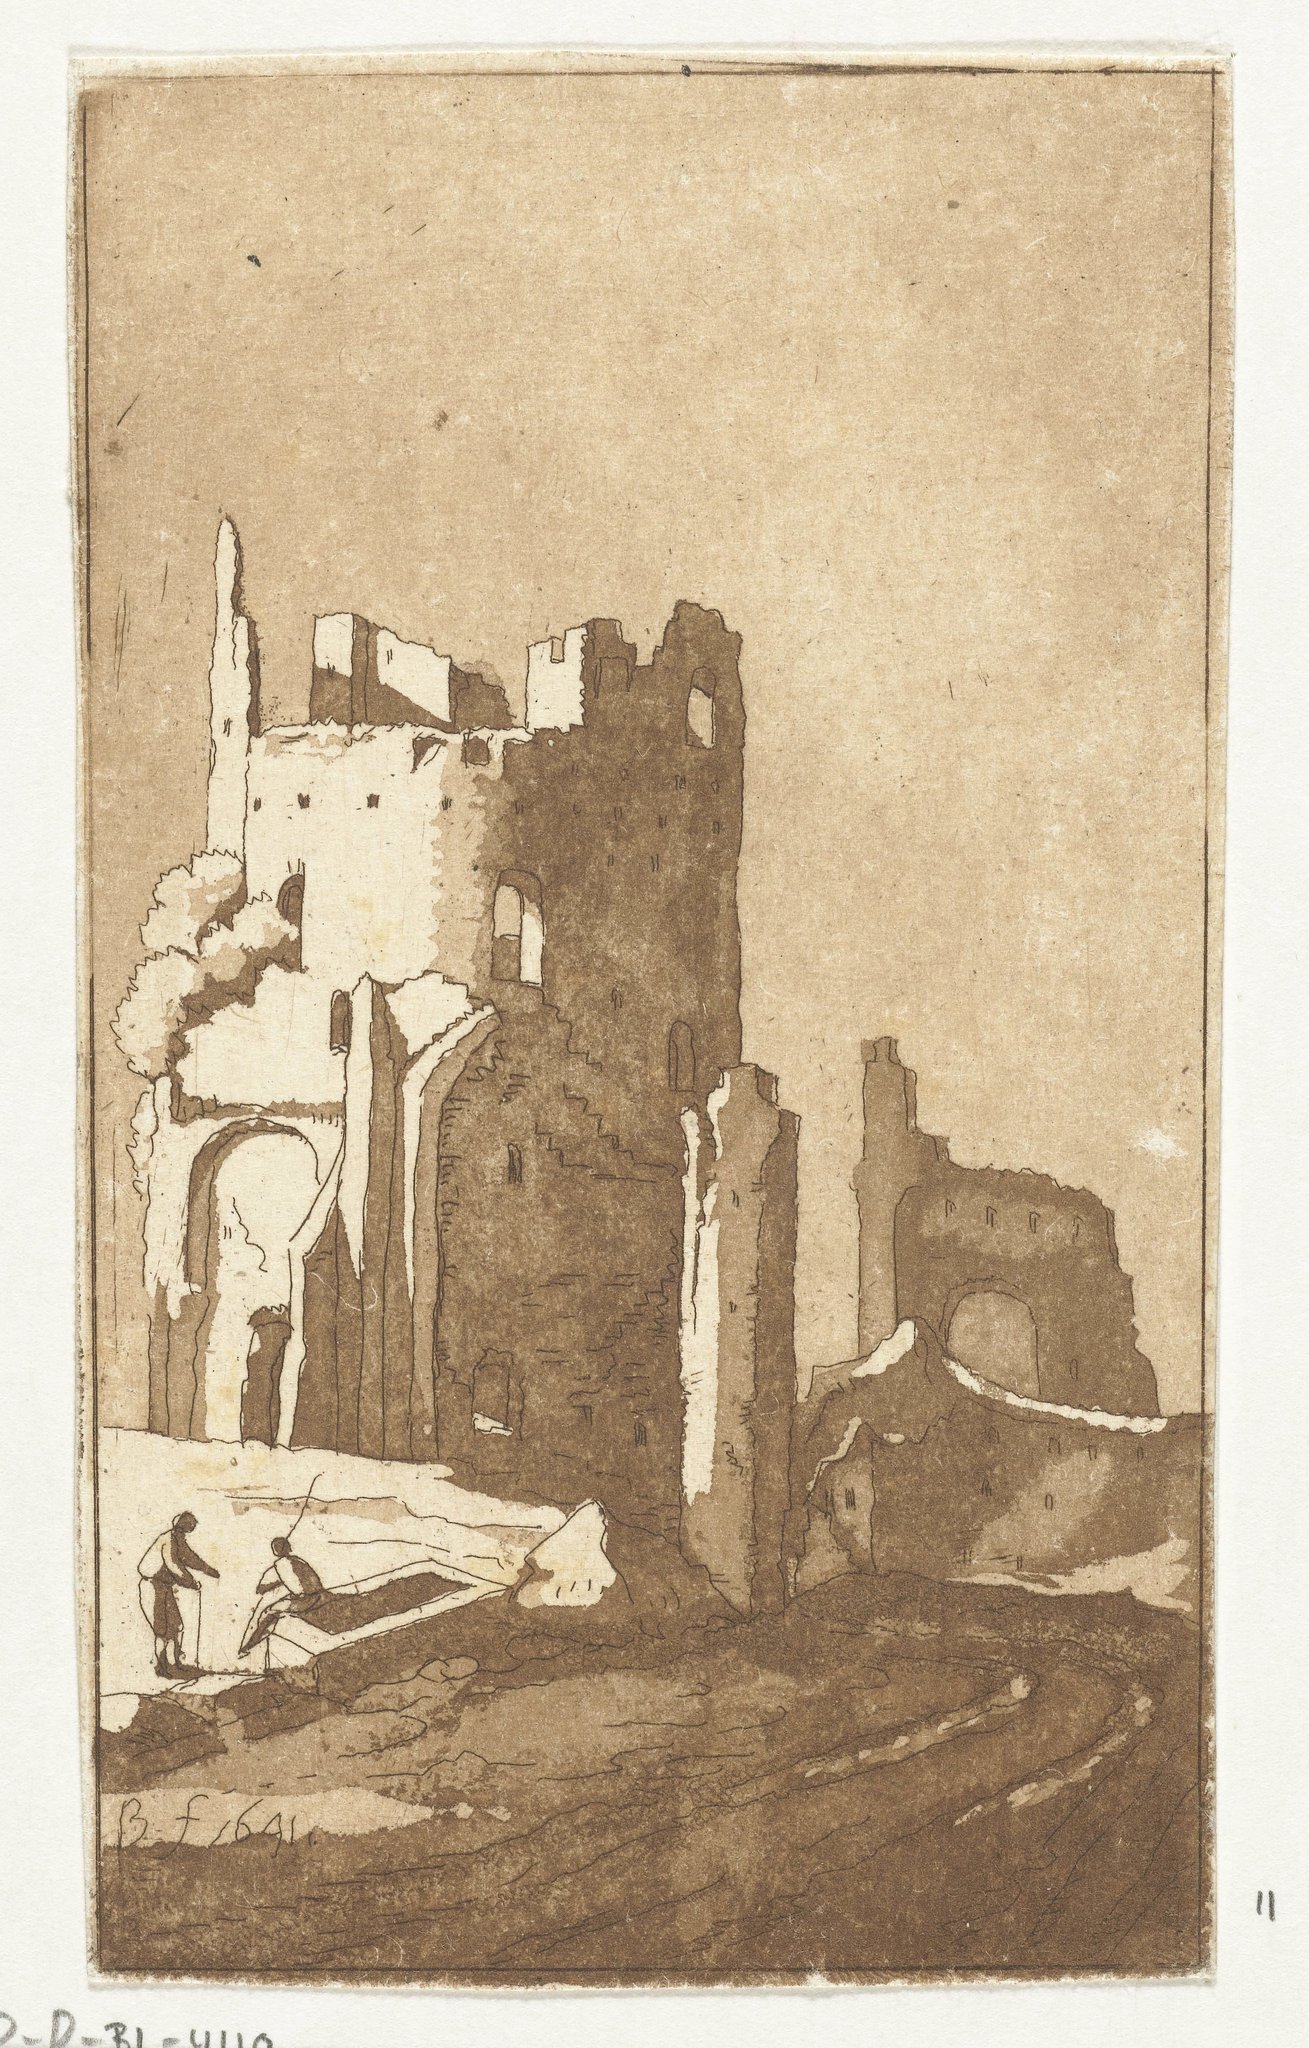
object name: print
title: Ruïne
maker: anthonie van den bos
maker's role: draughtsman, print maker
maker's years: 1763-1838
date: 1778-1838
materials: paper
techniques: aquatint, etching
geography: netherlands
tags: ruin of a dwelling, house, castle, etc.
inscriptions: collector's mark: Lugt 2228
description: Ruïne van een burcht, op de voorgrond twee figuren bij een waterbassin.